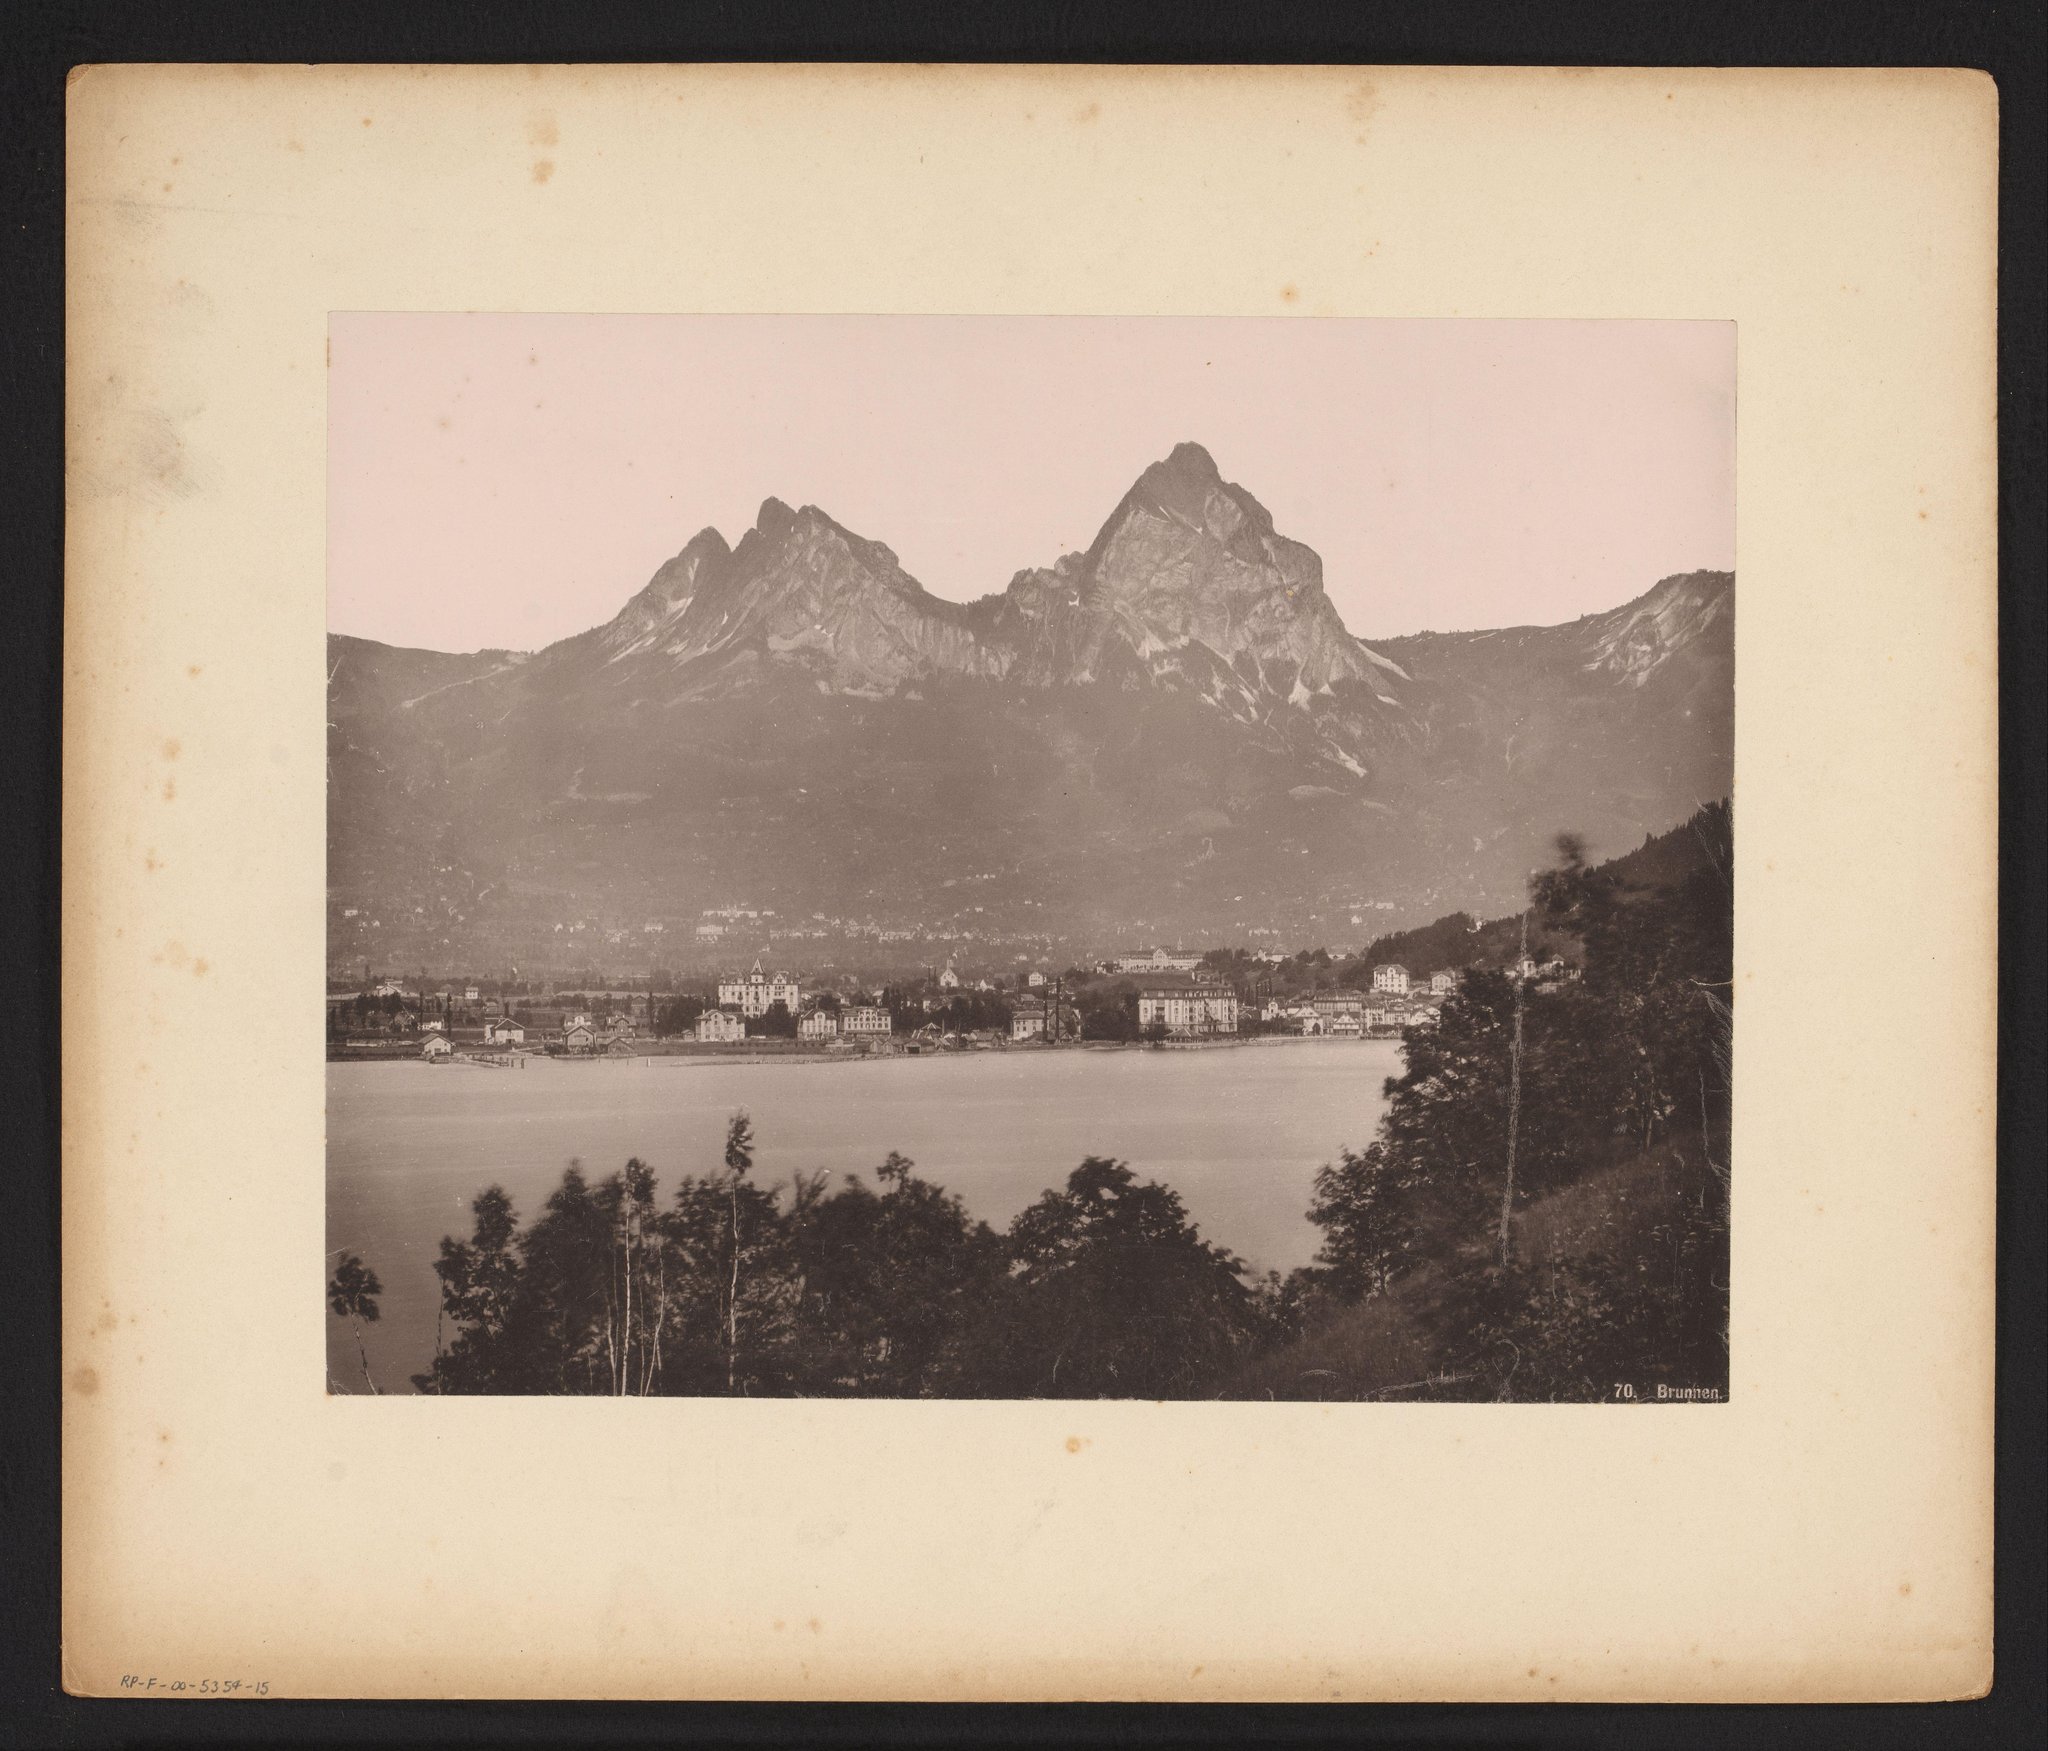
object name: photomechanical print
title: Brunnen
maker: Anonymous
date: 1890-1910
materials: cardboard, paper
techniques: photograph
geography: treib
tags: city-view in general; 'veduta', lake, mountains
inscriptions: inscription: ‘70. Brunnen’, number: ‘9’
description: Deze fotomechanische afdruk maakt deel uit van een omslag.